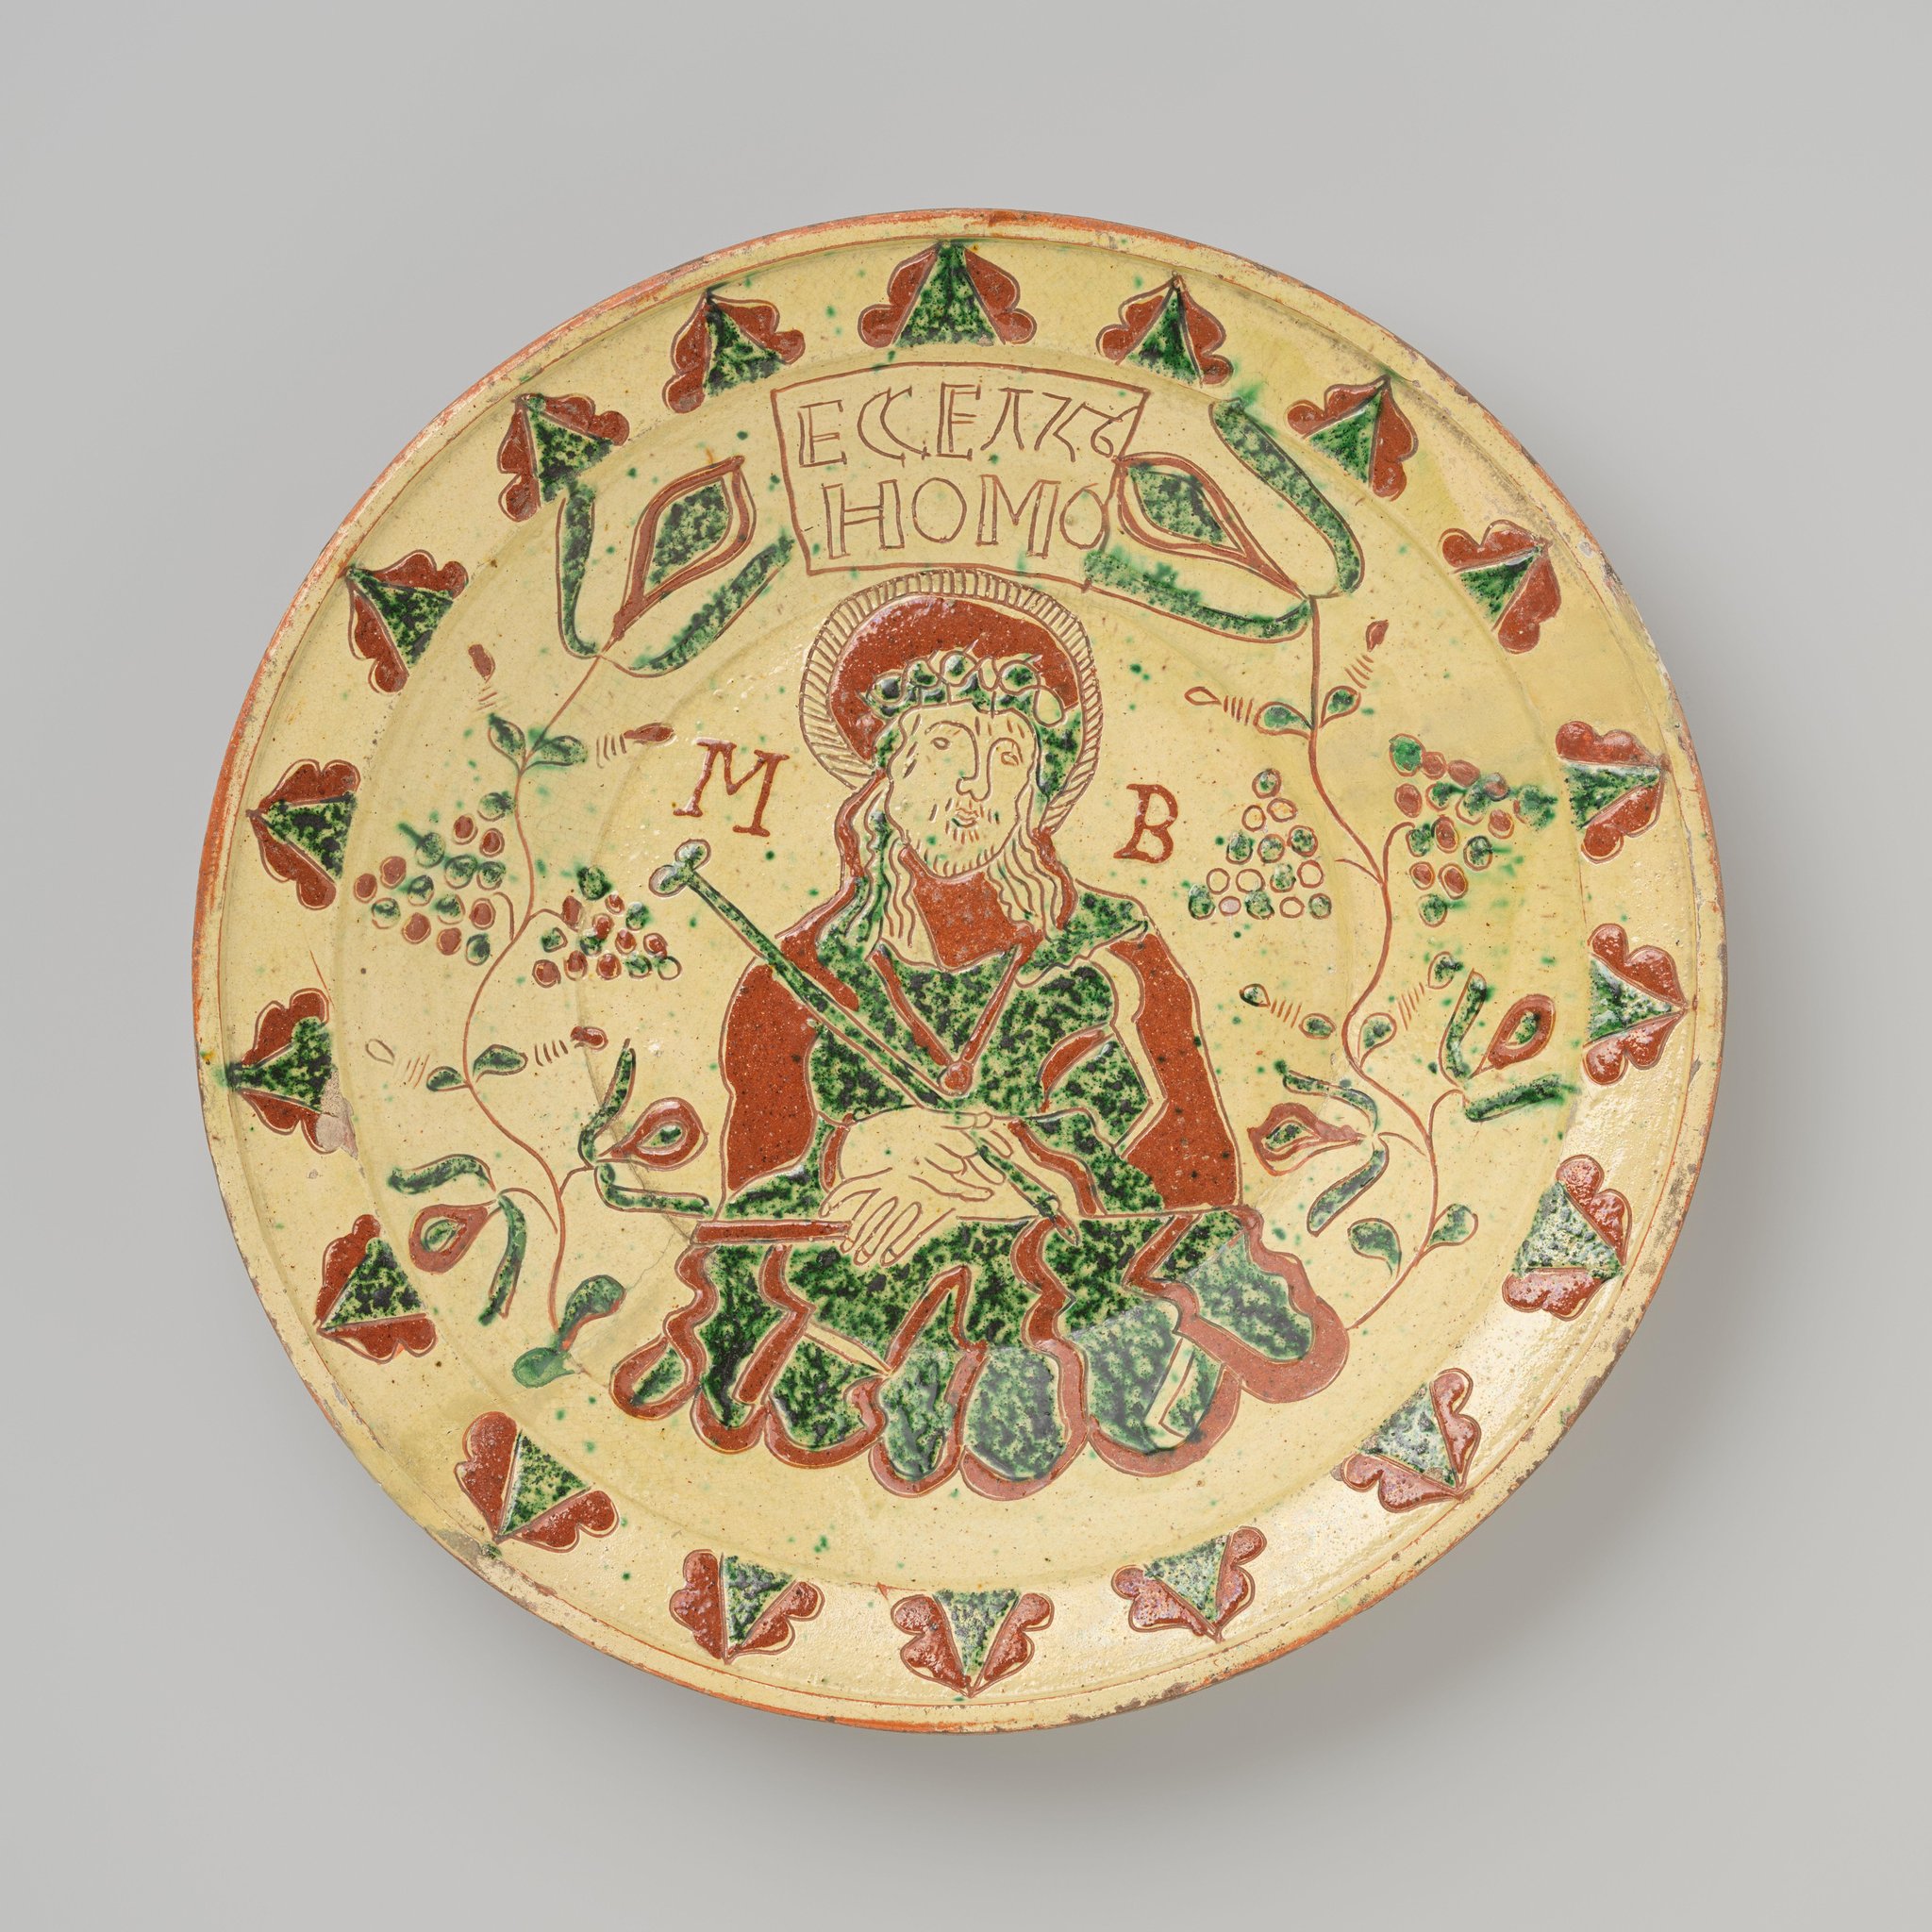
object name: platter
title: Ronde schotel van loodglazuuraardewerk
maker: hermannus van betteray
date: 1756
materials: earthenware, glaze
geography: sonsbeck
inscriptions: date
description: Ronde schotel van loodglazuuraardewerk, bedekt met een witte engobe. In het midden is Christus met gebonden handen, ten halven lijve in grafitto techniek afgebeeld. In zijn rechterhand heeft hij een stok. Links en rechts van hem is een rank geschilderd en boven zijn hoofd staat het opschrift "ECCO HOME 1756".